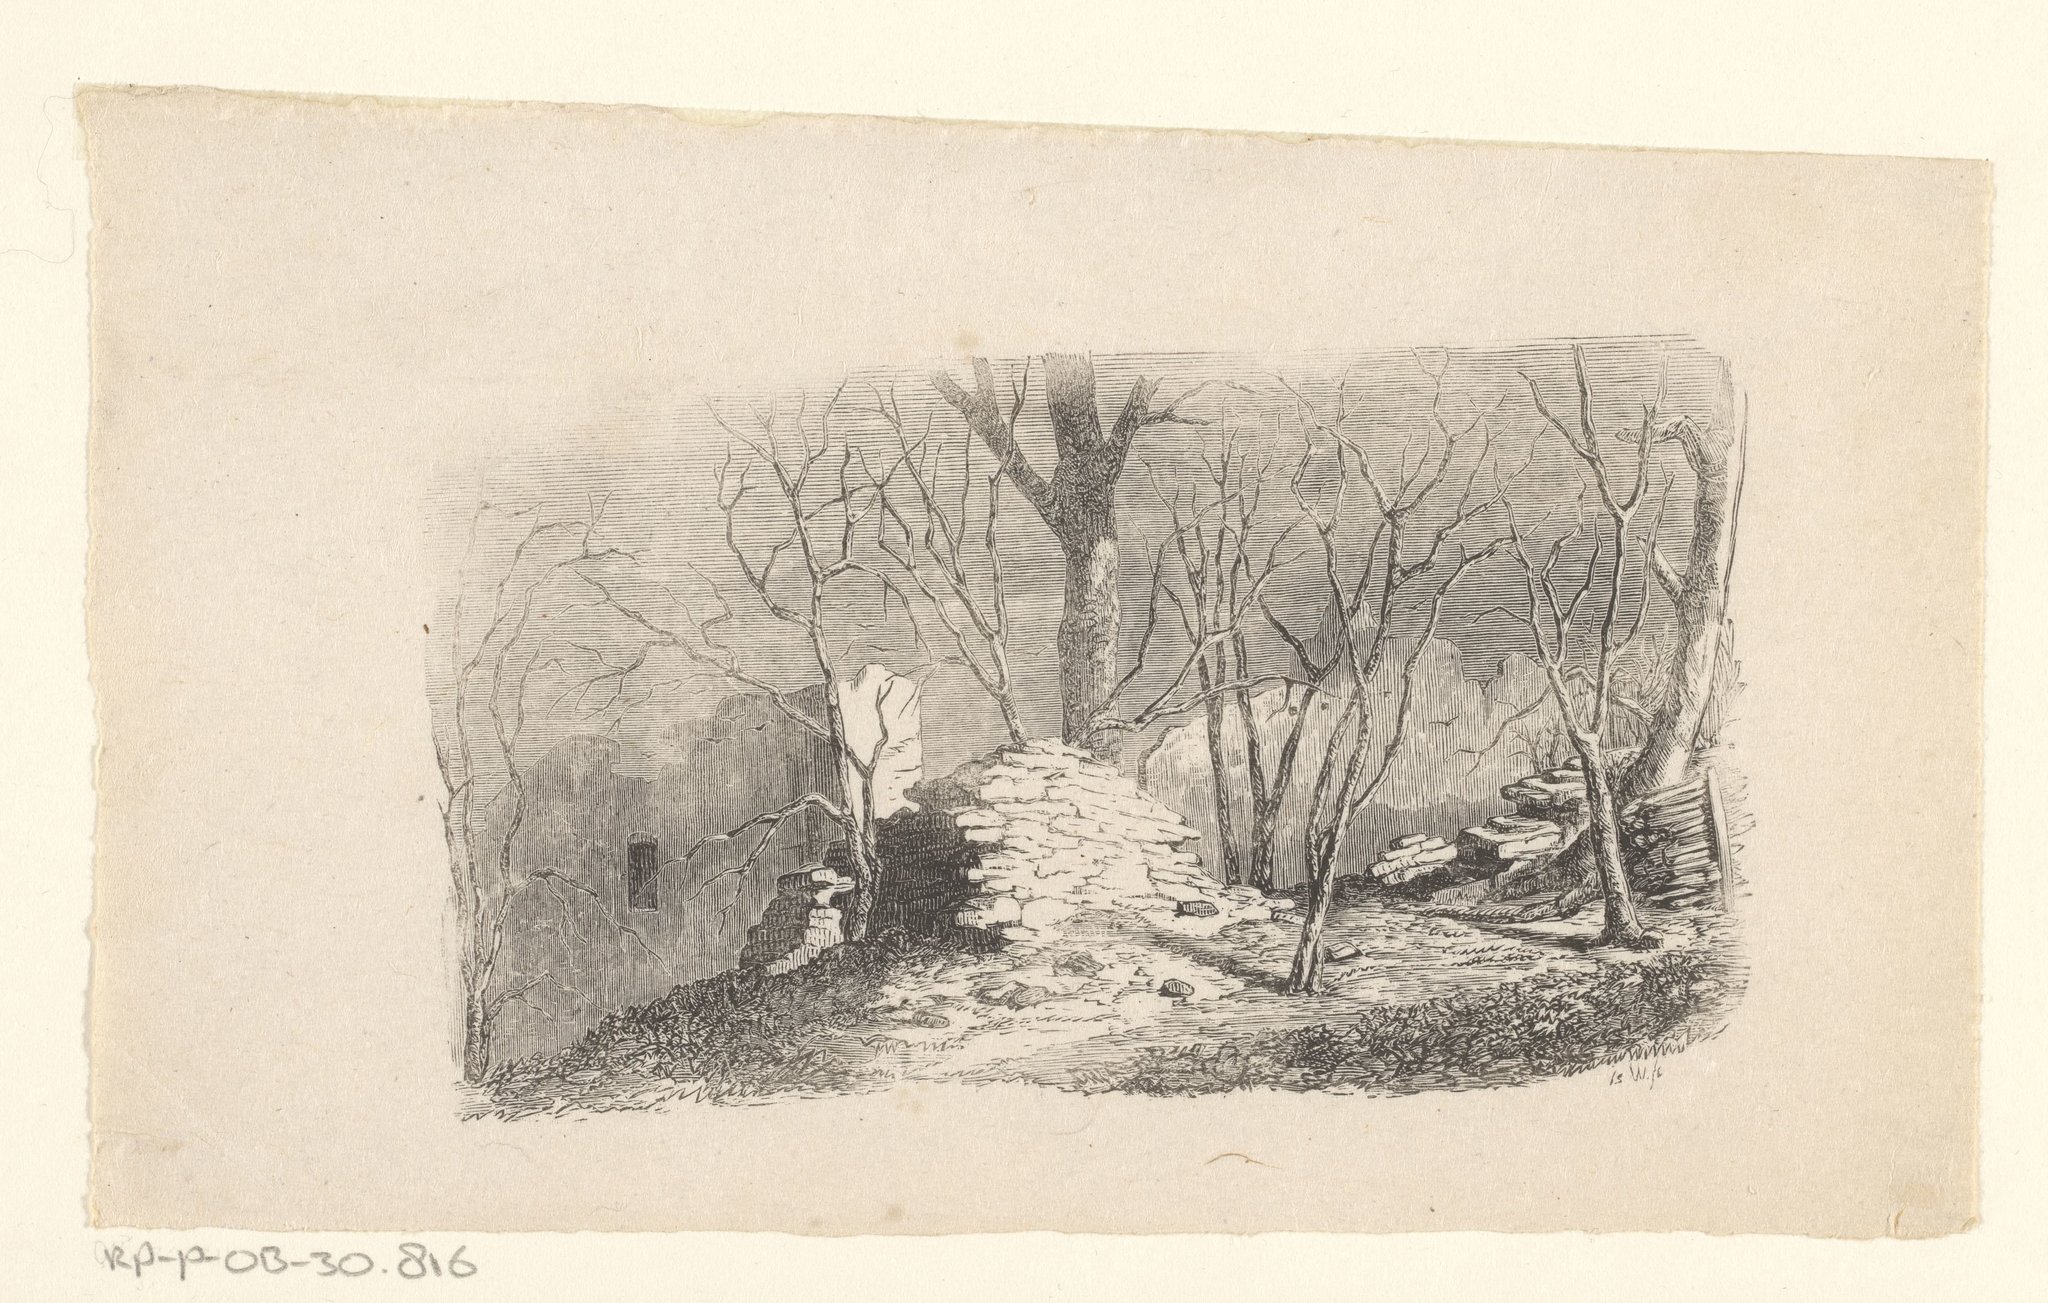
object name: print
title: Ruïne te midden van kale bomen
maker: isaac weissenbruch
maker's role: print maker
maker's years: 1826-1912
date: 1836-1912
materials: paper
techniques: engraving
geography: netherlands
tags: trees, ruin of a dwelling, house, castle, etc.